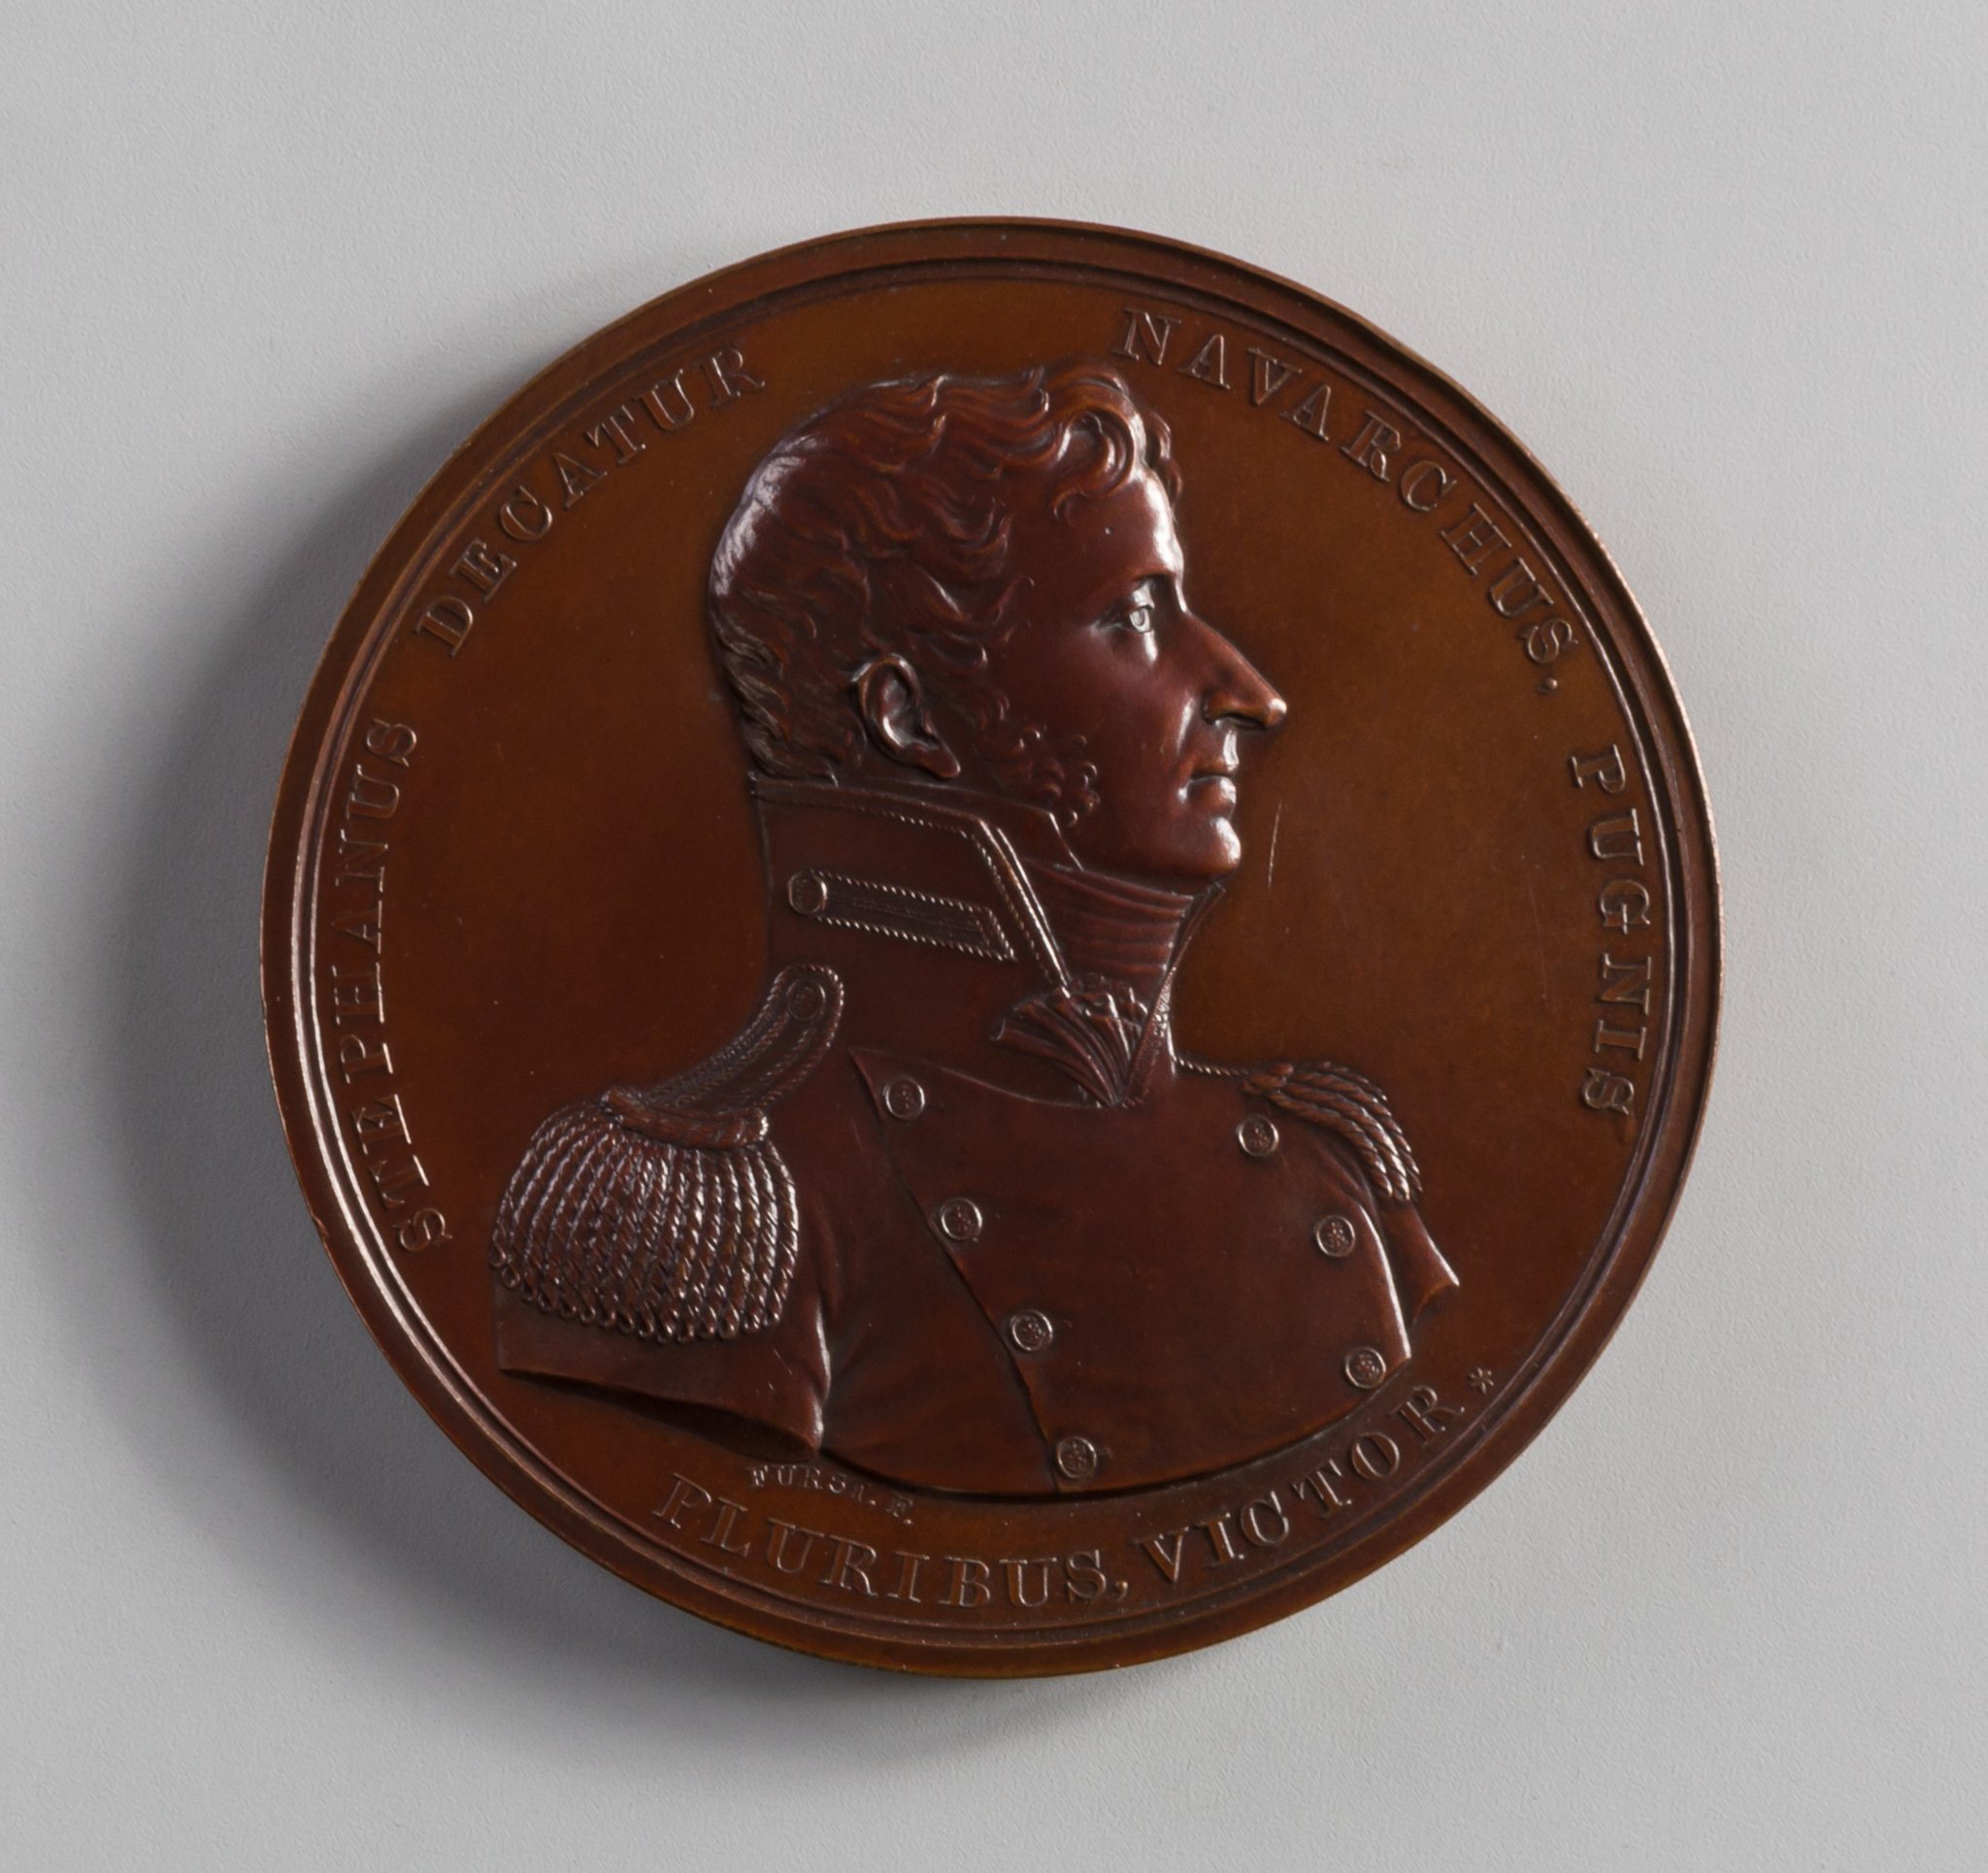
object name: medal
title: Medal of Captain Stephen Decatur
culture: american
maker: moritz fürst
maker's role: maker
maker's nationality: hungarian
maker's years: 1782-1882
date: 1800-1830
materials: bronze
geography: united states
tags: men,profiles